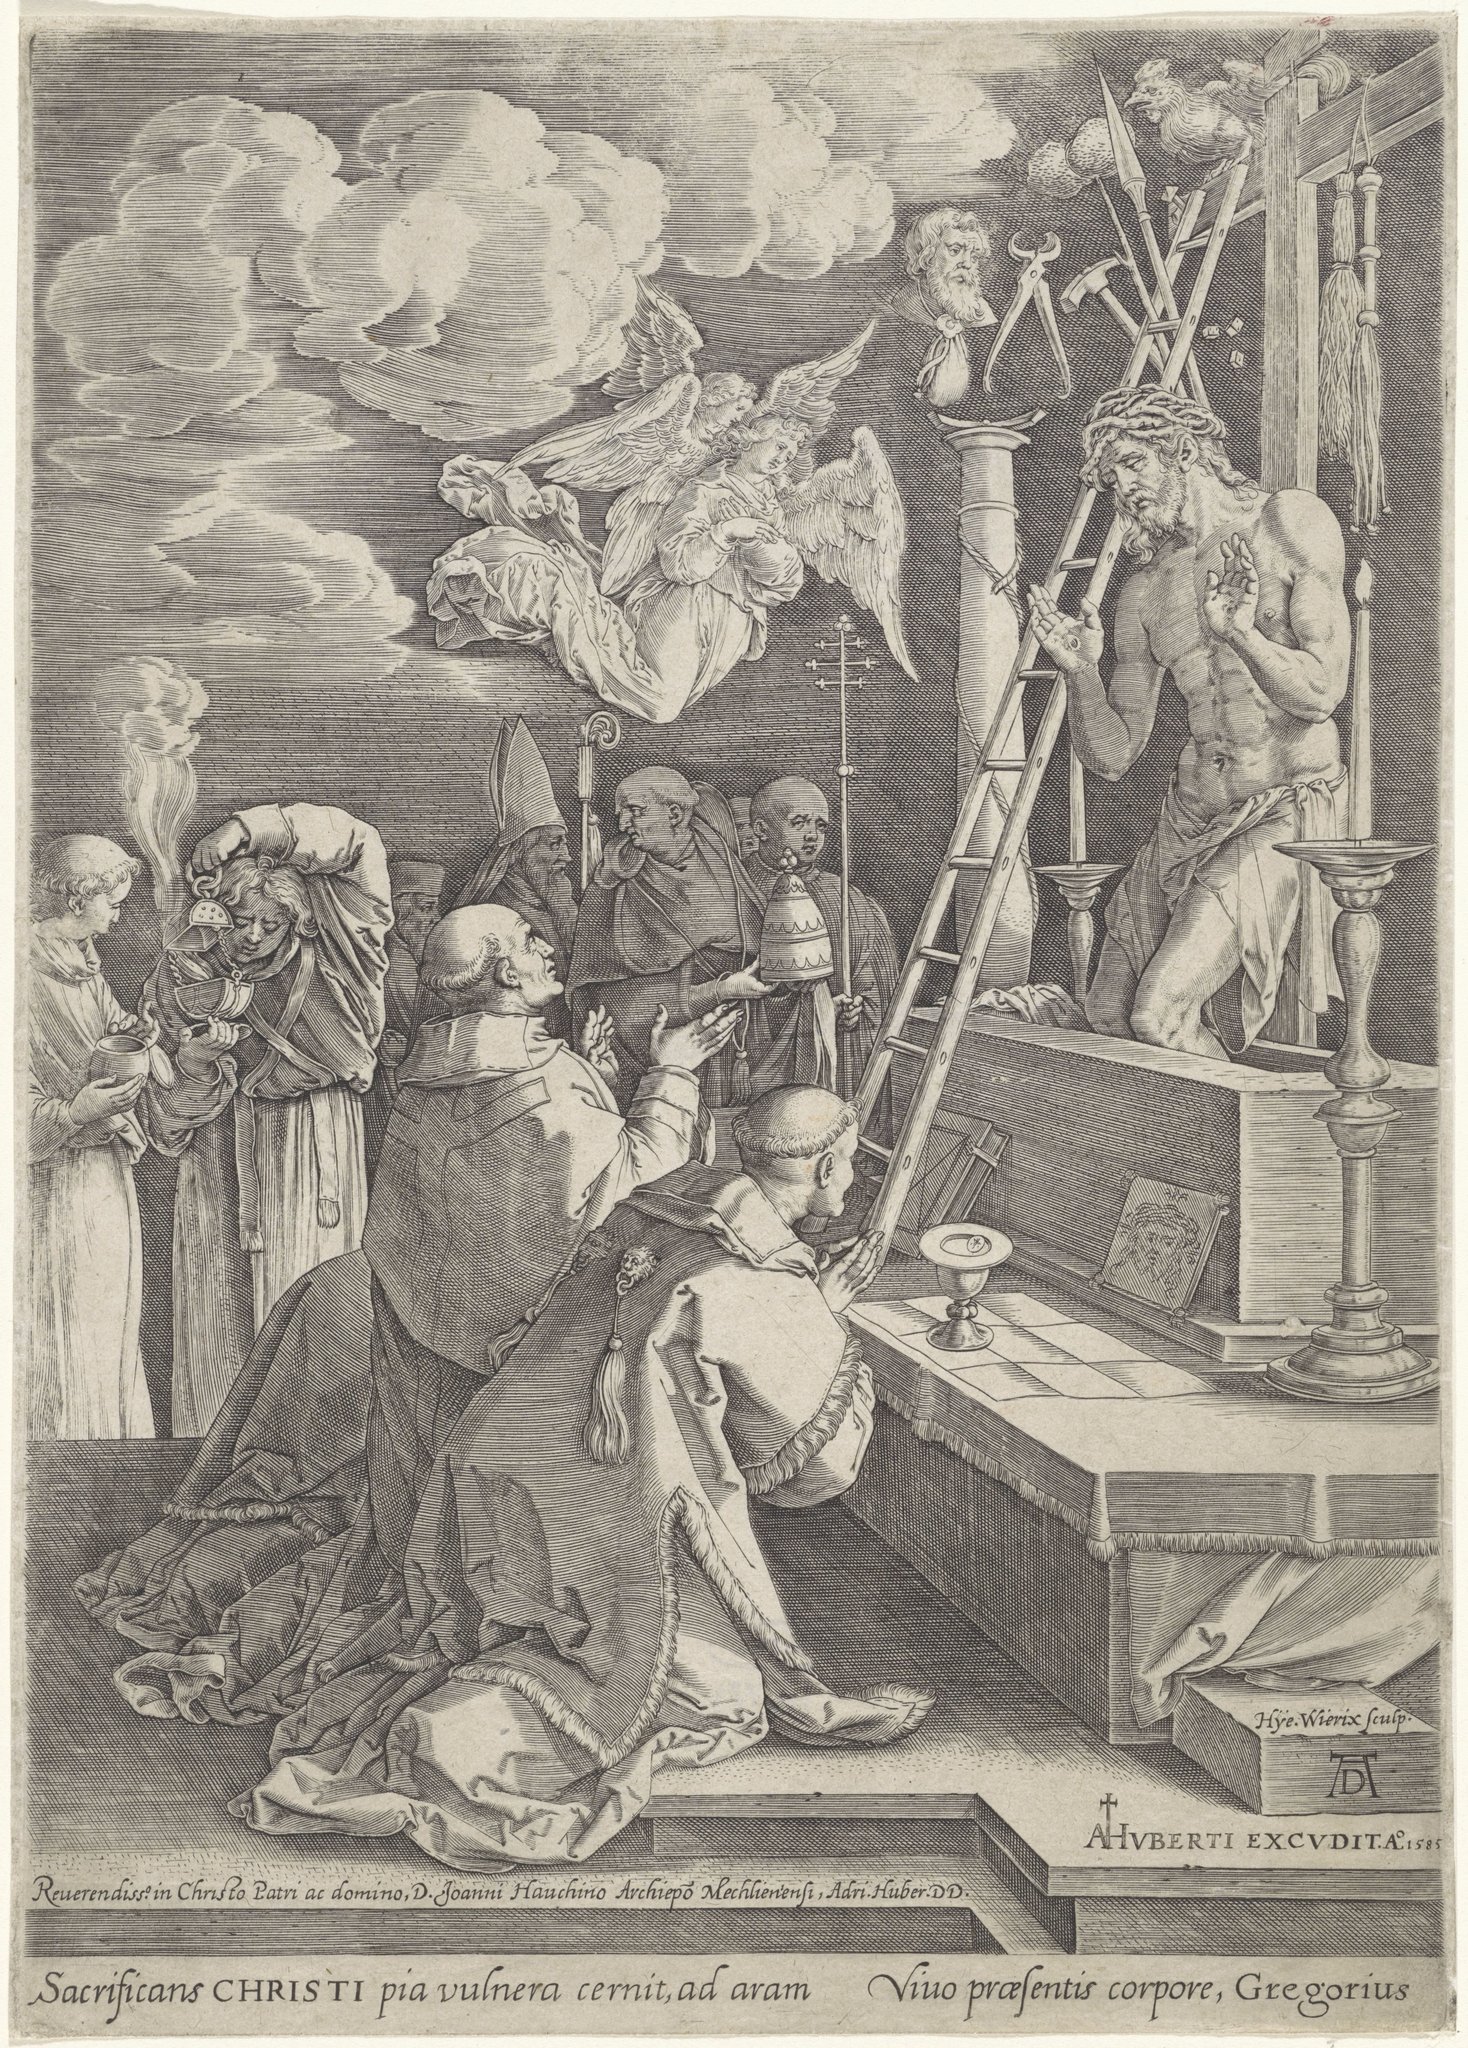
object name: print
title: Gregoriusmis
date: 1585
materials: paper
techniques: engraving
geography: antwerp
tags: the mass of st. gregory the great: christ appears above the altar with the instruments of the passion; maybe blood spouts from christ's side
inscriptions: collector's mark: Lugt 2228, collector's mark: Lugt 1425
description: De heilige Gregorius aanschouwt, geknield voor een altaar en geflankeerd door twee mannen, Christus als Man van Smarten. Op de achtergrond nog een aantal mensen. In de lucht twee engelen. Rechts op een steen onder het altaar het monogram van Albrecht Dürer. In de marge een onderschrift in het Latijn.